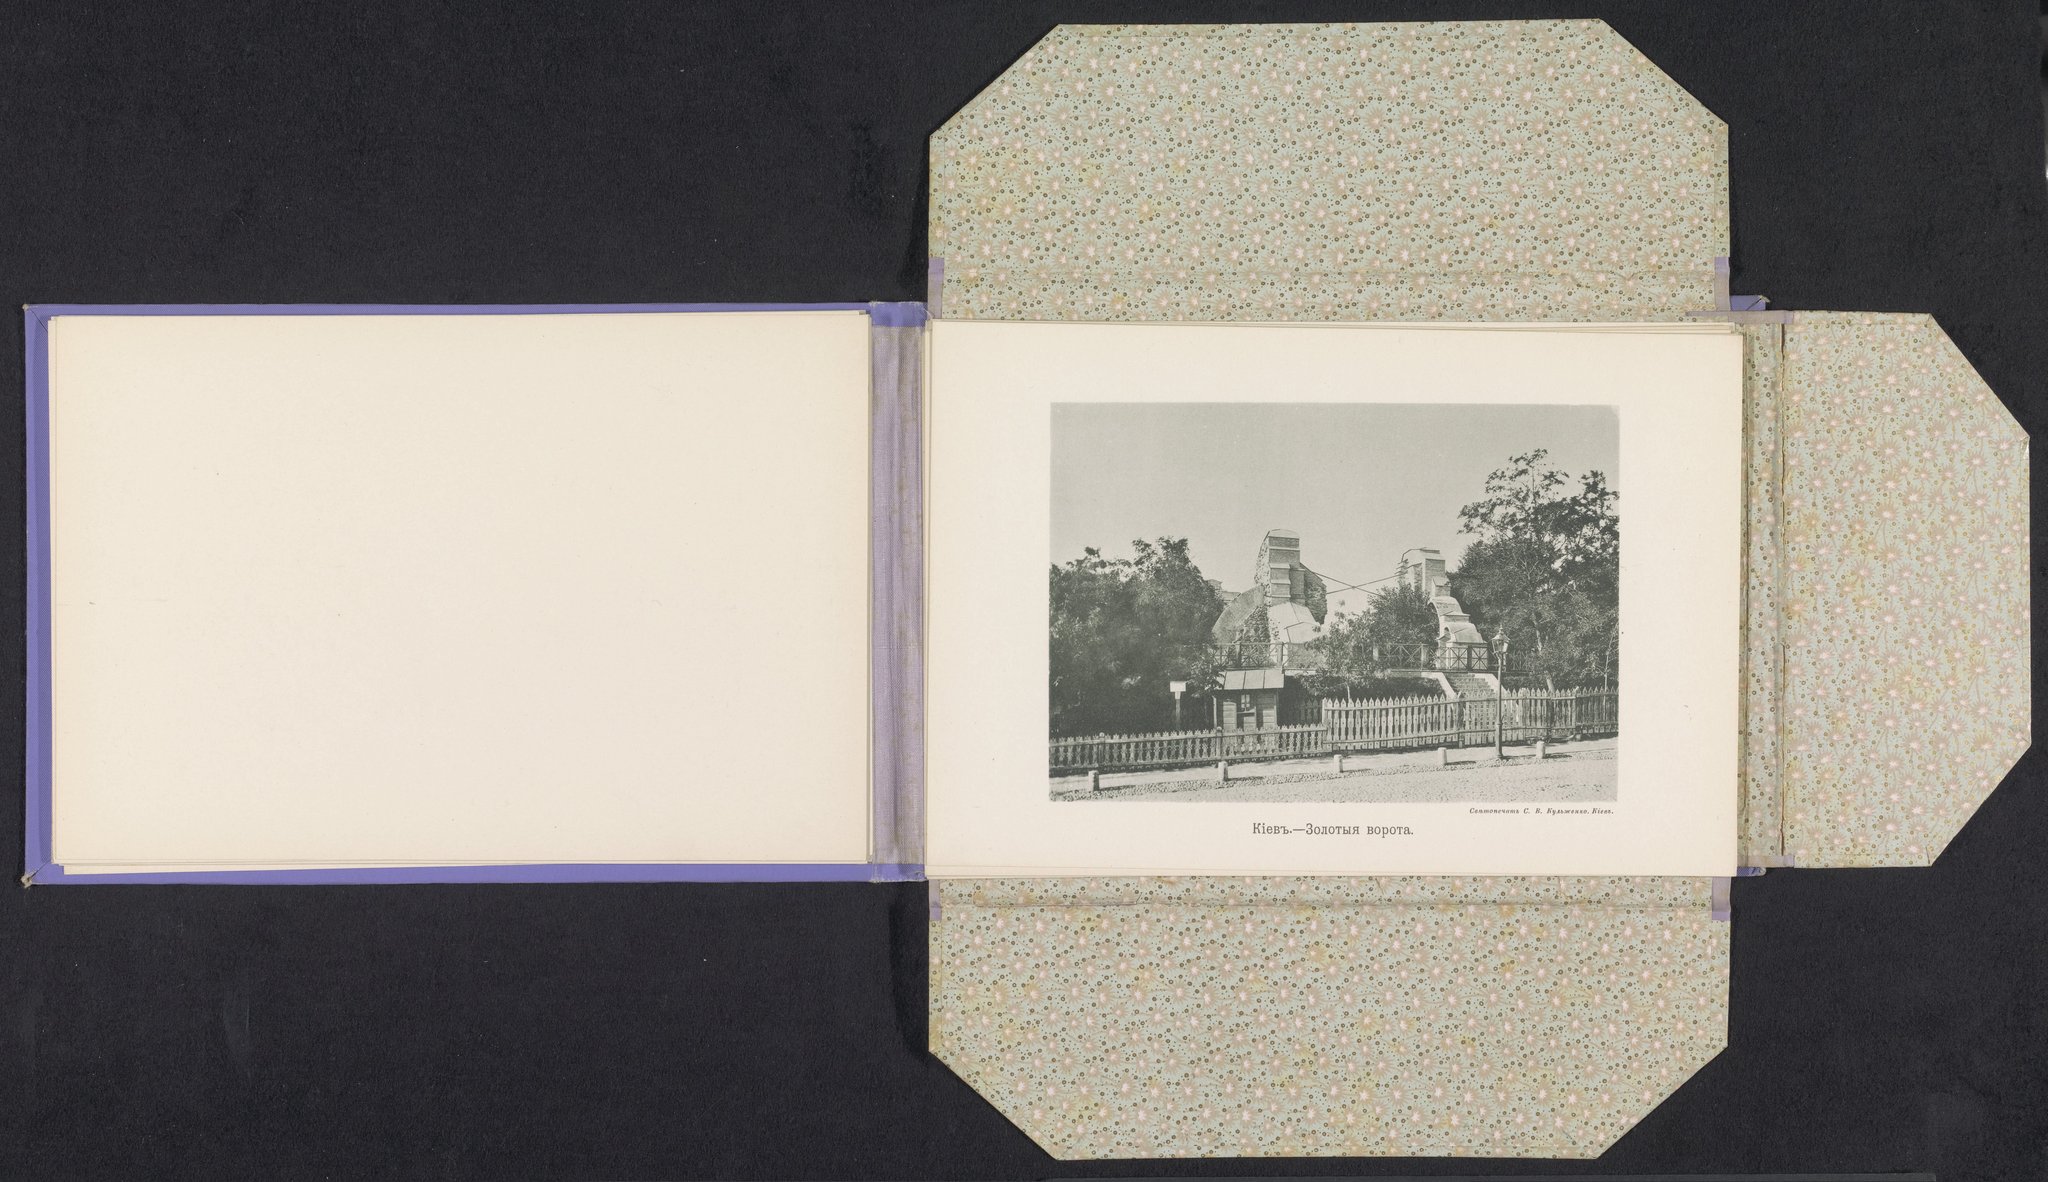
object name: page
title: Ruïne van de Gouden Poort te Kiev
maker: Anonymous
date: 1886-1896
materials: paper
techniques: photograph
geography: kyiv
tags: ruin of a building ~ architecture, city-gate